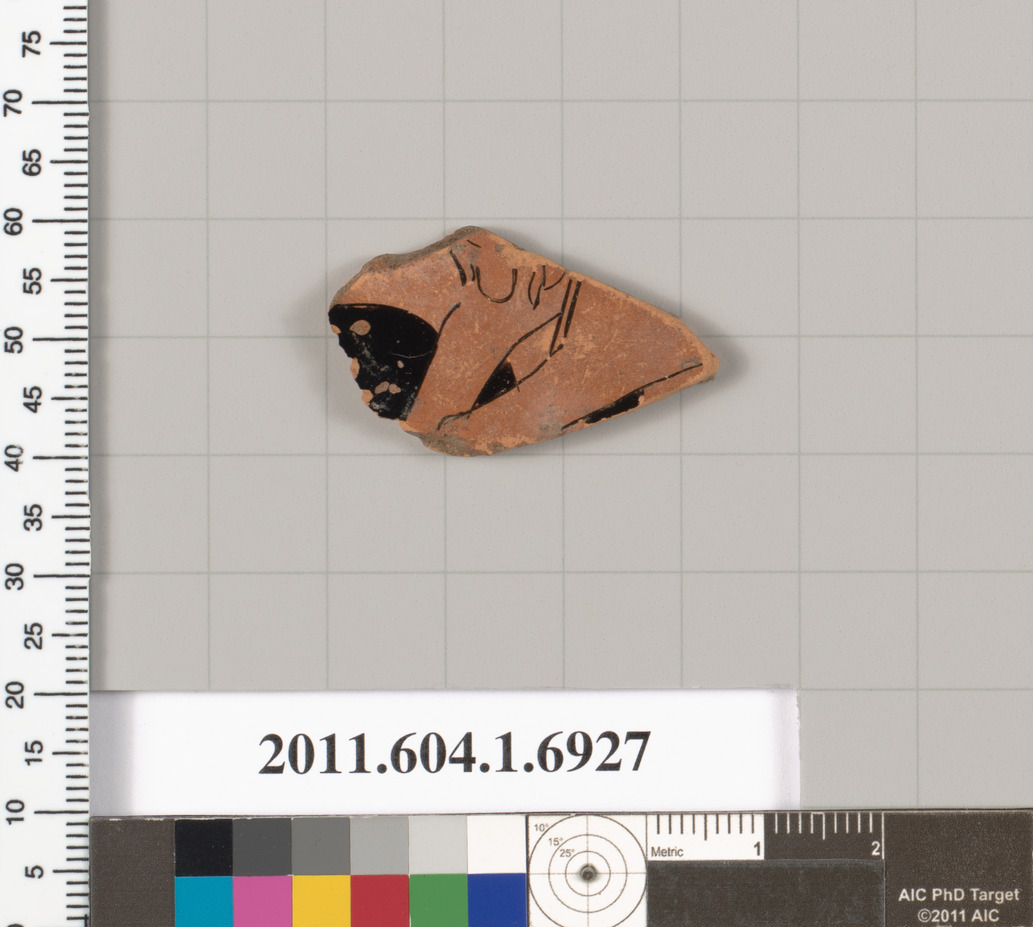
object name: kylix fragment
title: Terracotta fragment of a kylix (drinking cup)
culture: greek, attic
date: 490-470 BCE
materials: terracotta